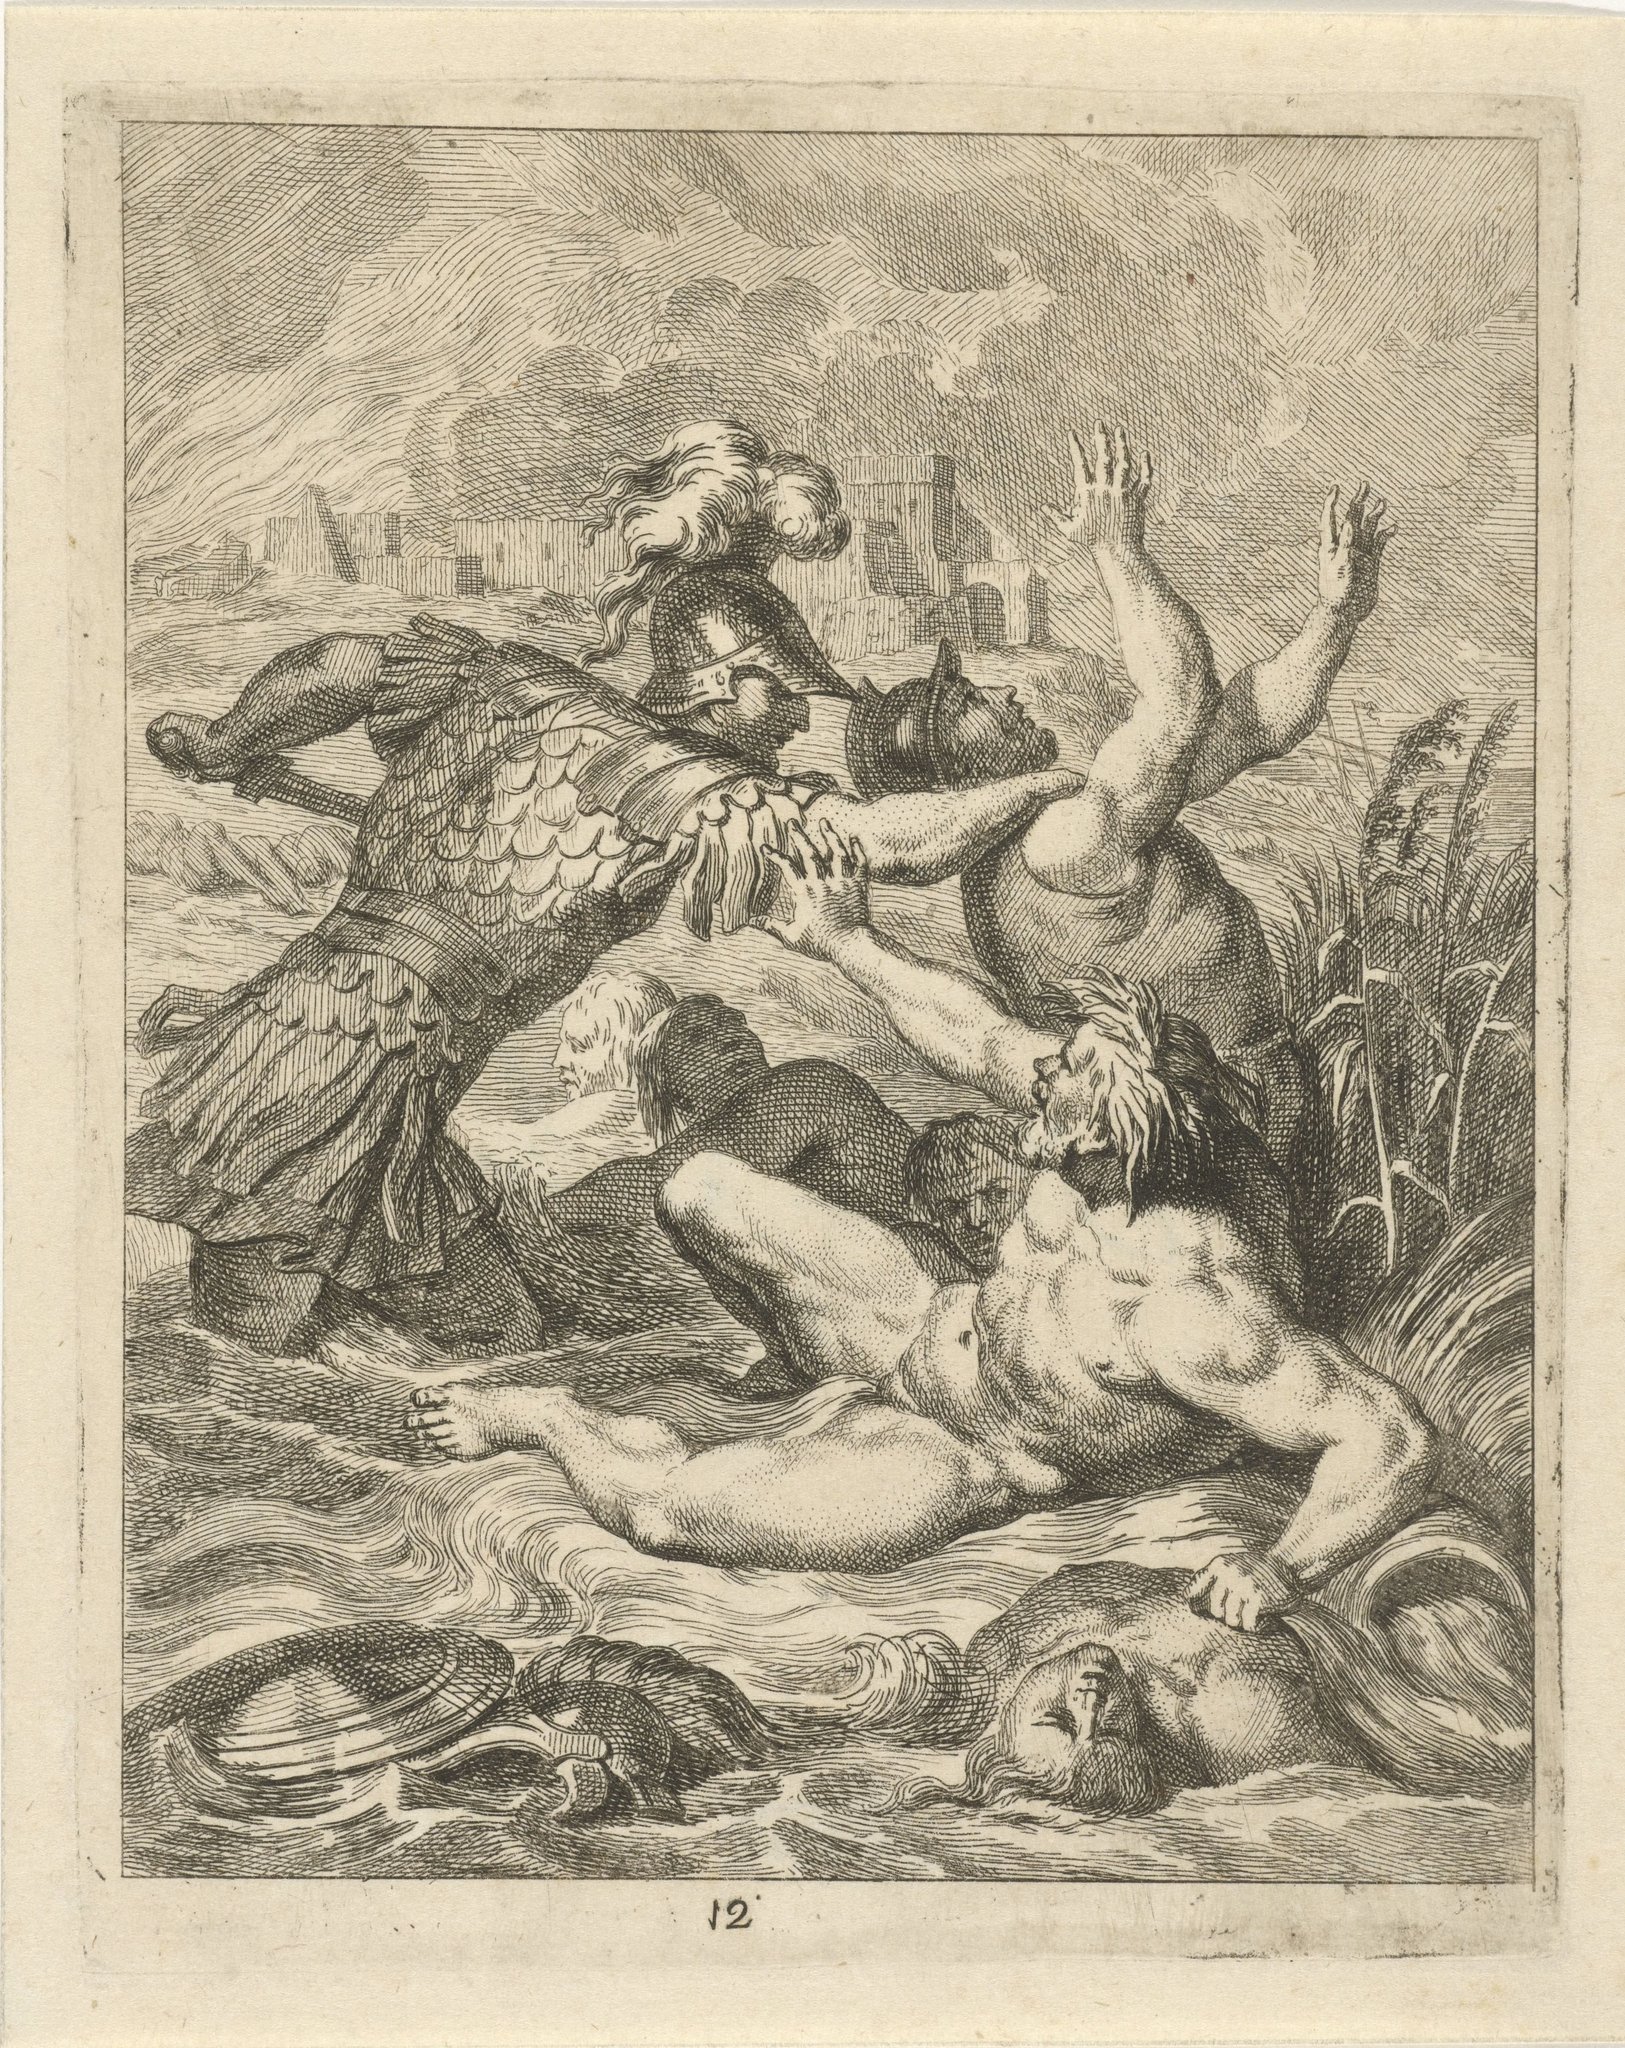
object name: print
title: Achilles vecht met riviergod Scamander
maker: j. alexander janssens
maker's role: print maker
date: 1700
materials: paper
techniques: engraving, etching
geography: southern netherlands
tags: achilles fights the river-gods scamander and simois; achilles is assisted by vulcan, who dries up the waters with scorching flames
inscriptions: collector's mark: Lugt 2228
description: Achilles, staand in rivier met woest stromend water. Op de voorgrond de riviergod Scamander, reikend naar de arm van Achilles, die op het punt staat een Trojaanse soldaat met zijn zwaard te steken. Op de achtergrond een brandende stad. Midden onder: 12. Twaalfde prent uit een serie van veertien met scènes uit het leven van Achilles.